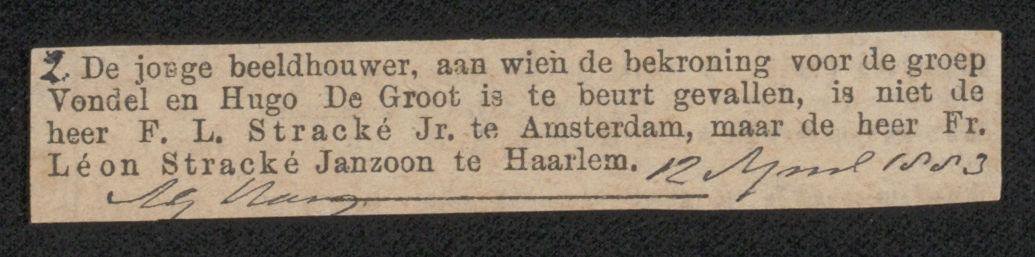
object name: newspaper clipping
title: Krantenknipsel betreffende Frans Stracké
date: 1883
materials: paper, ink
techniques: printing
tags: painter, frans stracké, sculpture